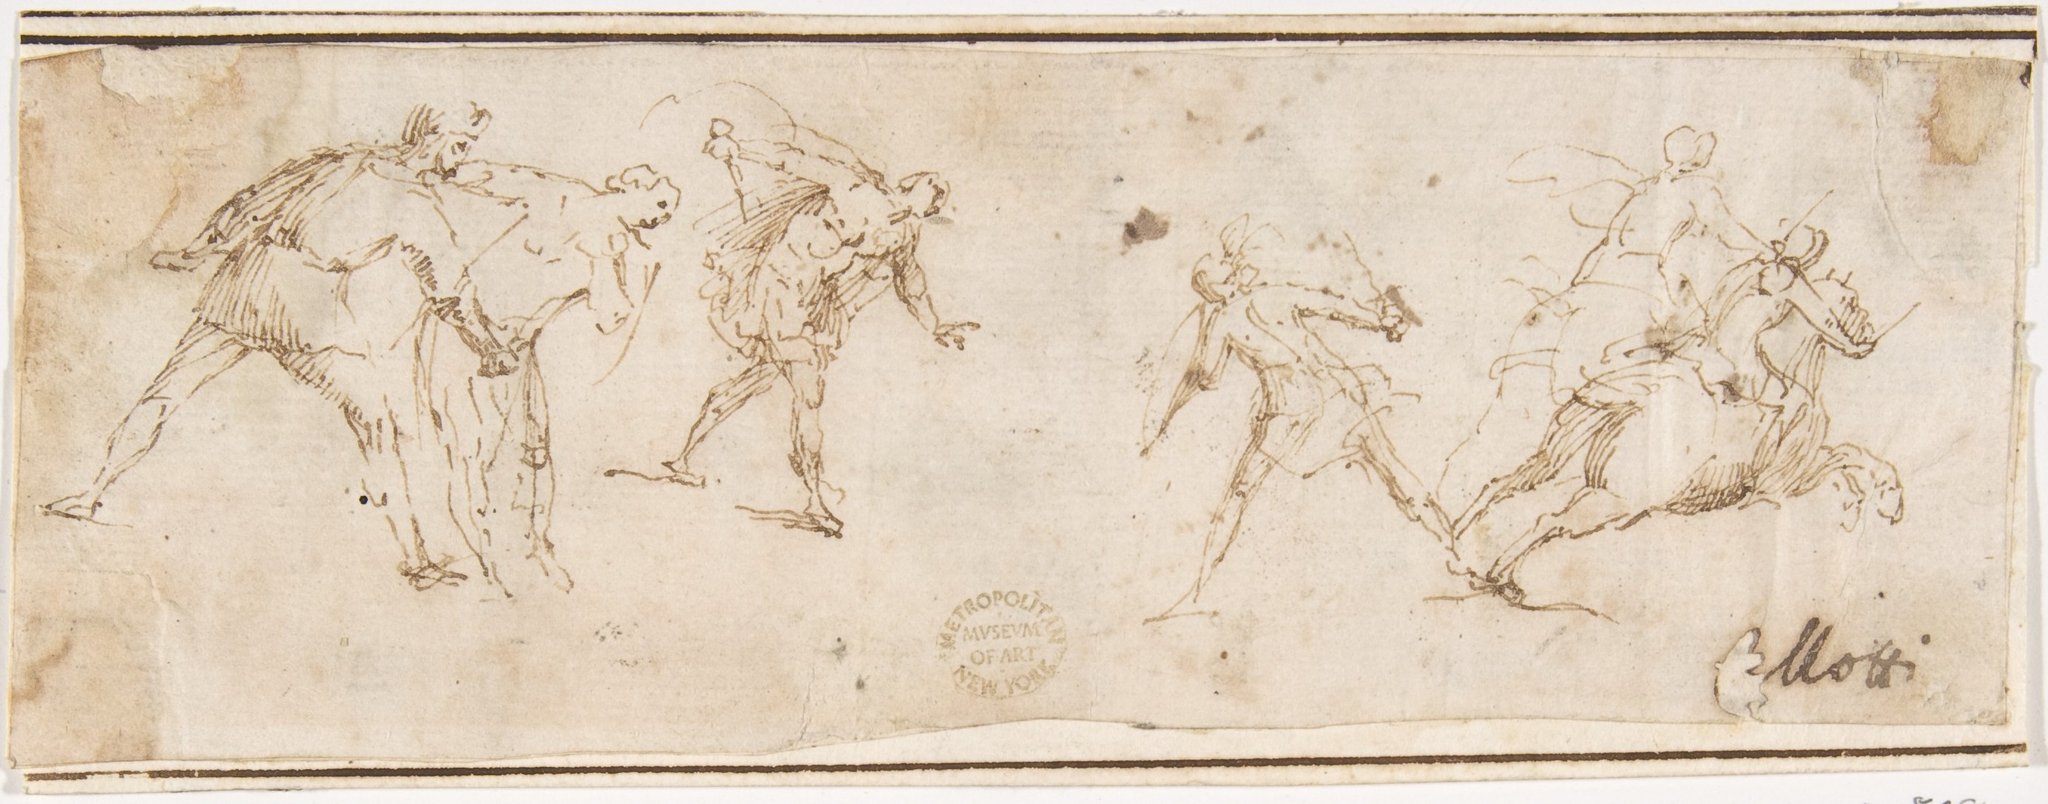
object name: drawing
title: Soldiers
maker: francesco allegrini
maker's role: artist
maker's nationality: italian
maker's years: 1615-1679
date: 1624-1663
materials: ink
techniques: pen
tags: soldiers,men,horses